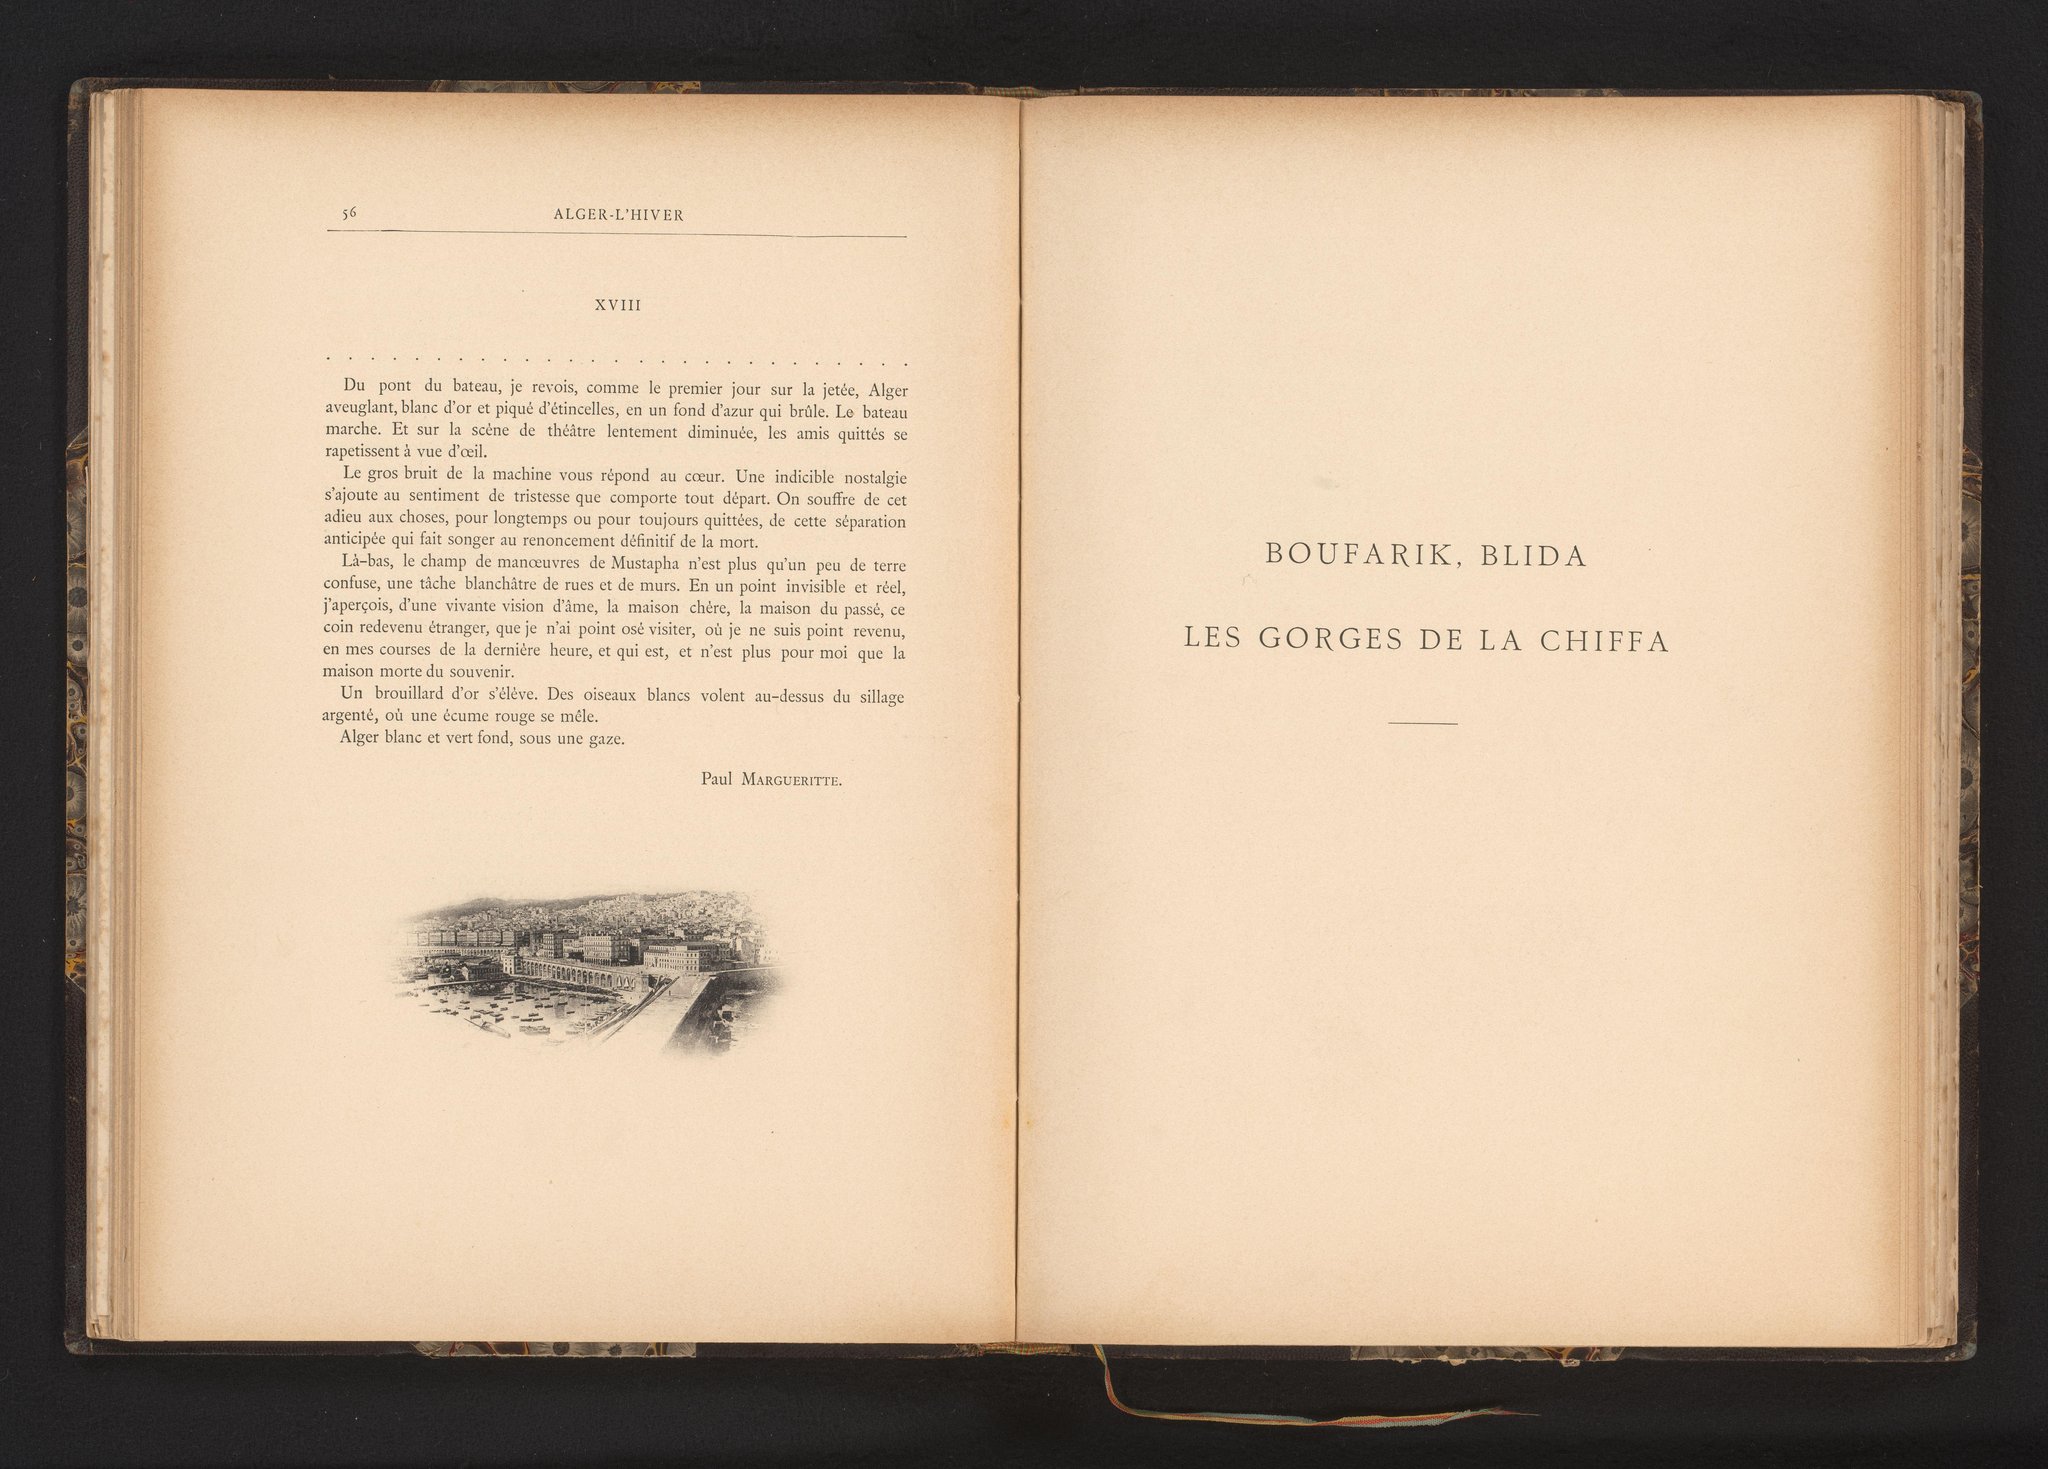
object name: photomechanical print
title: Gezicht op Algiers, Algerije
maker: jules gervais-courtellemont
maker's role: fotograaf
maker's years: 1863-1931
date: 1888-1893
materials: paper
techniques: photograph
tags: prospect of city, town panorama, silhouette of city